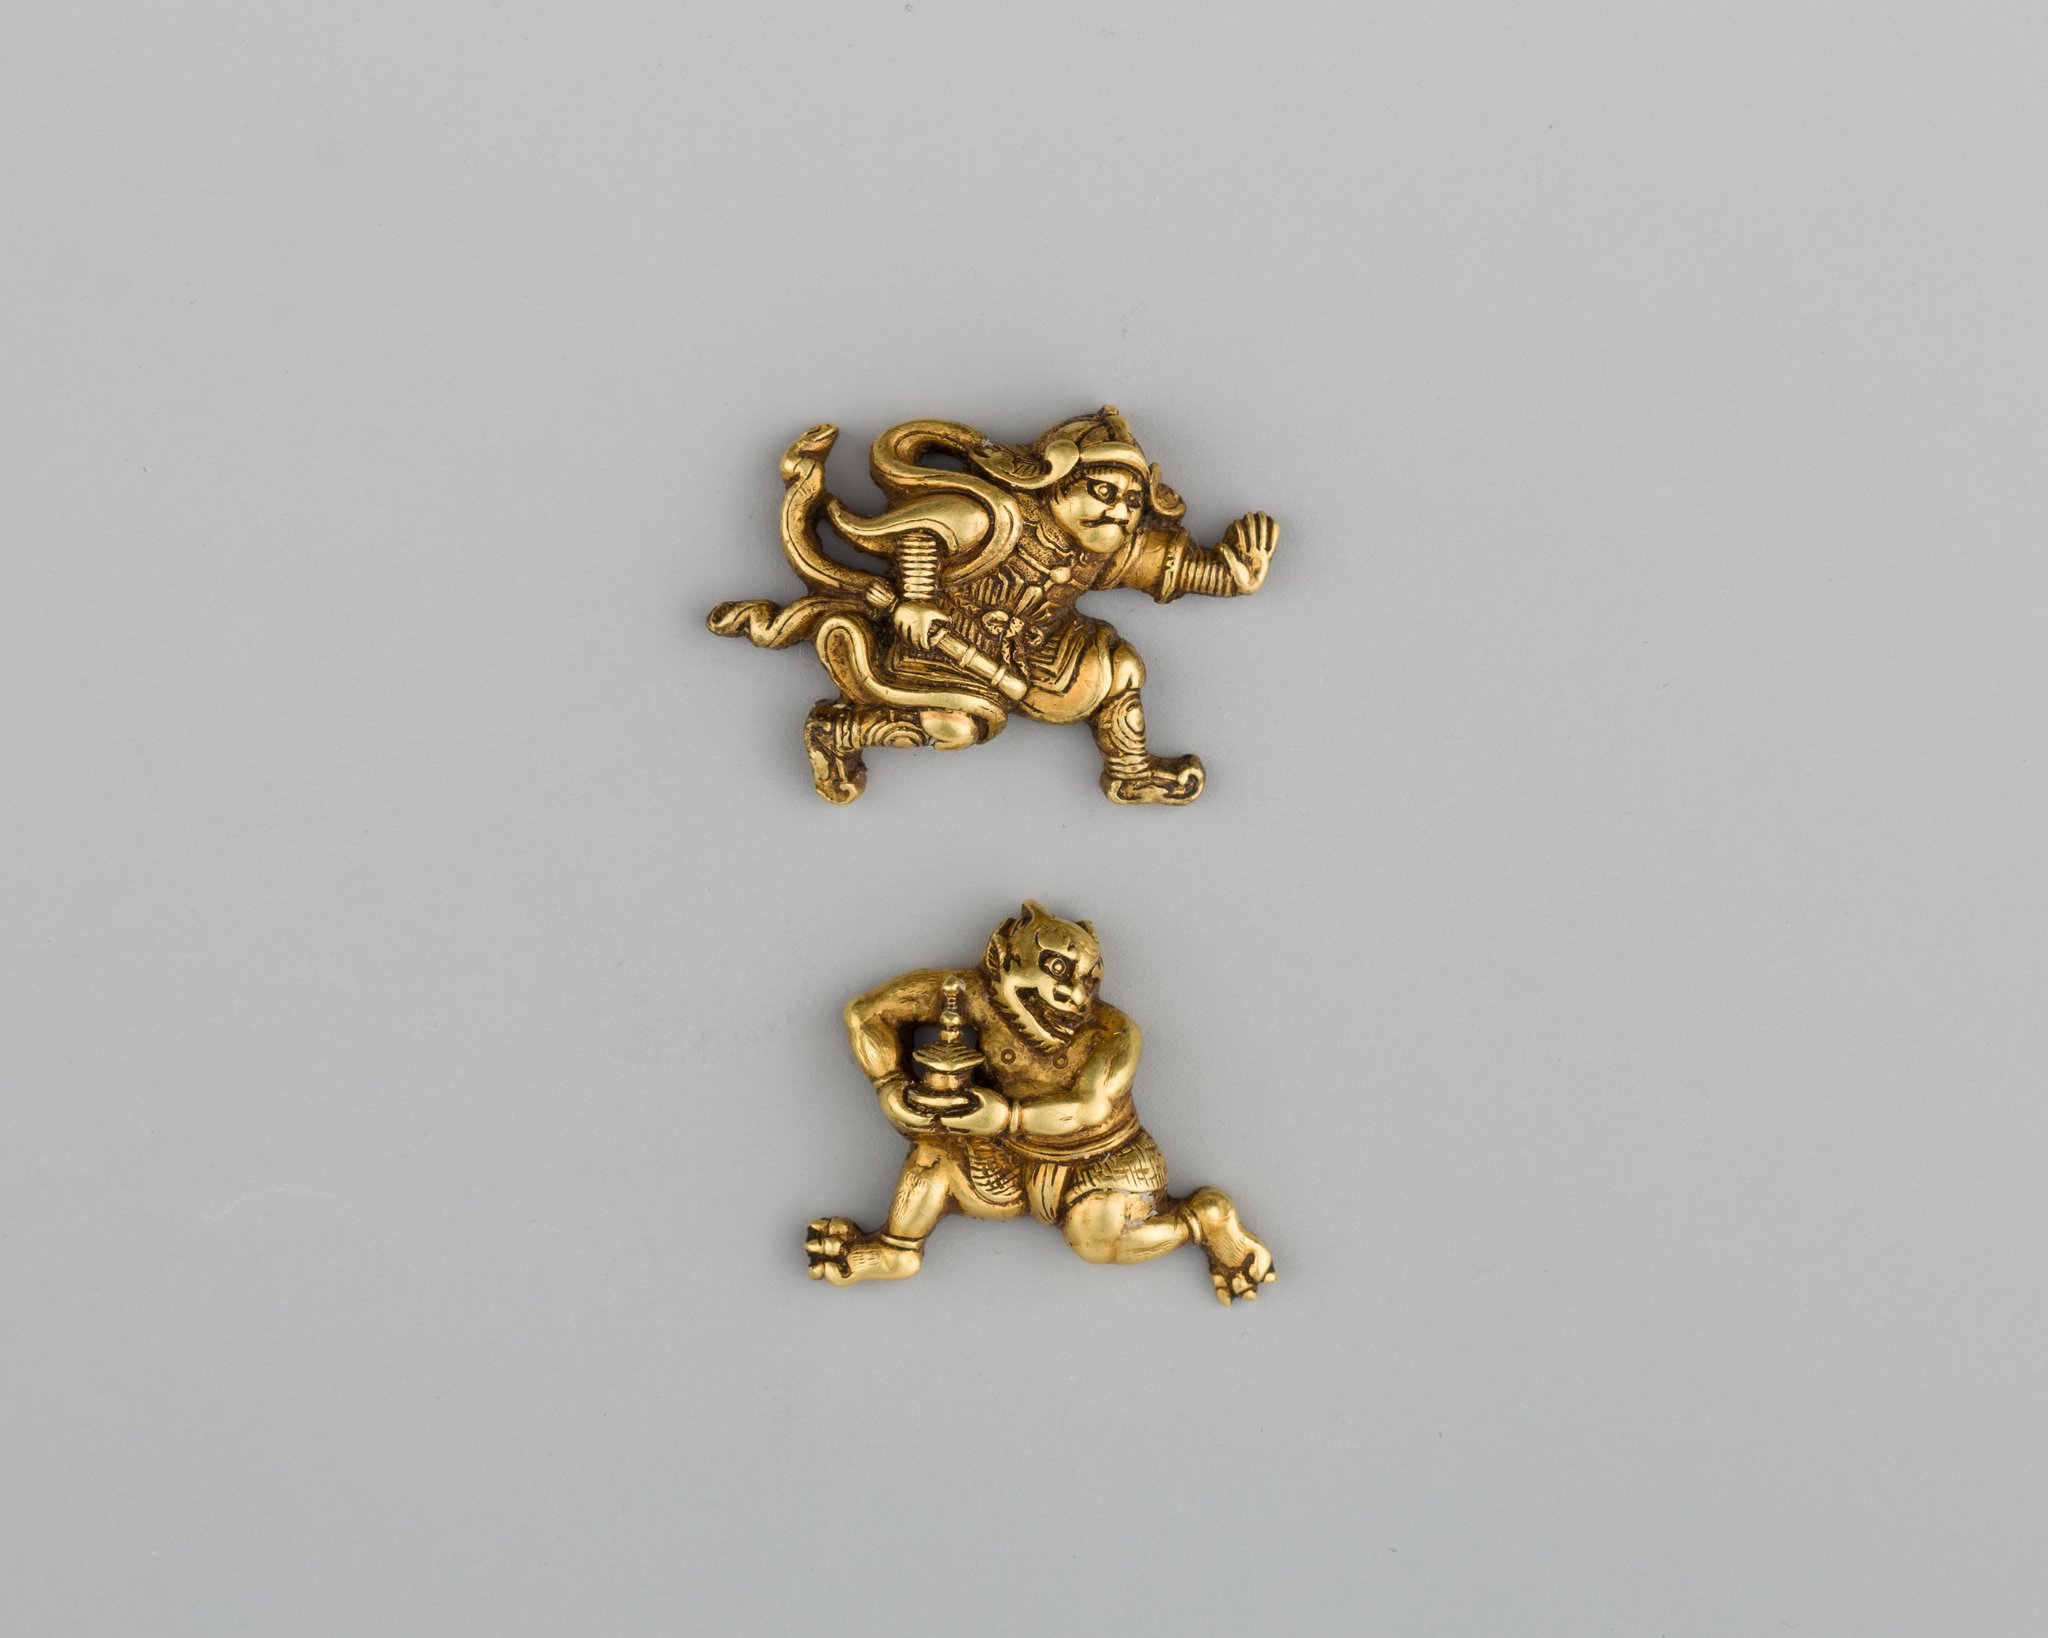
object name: pair of sword grip ornament menuki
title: Pair of Sword-Grip Ornaments (Menuki)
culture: japanese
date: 1501-1600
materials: gold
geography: japan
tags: men,demons